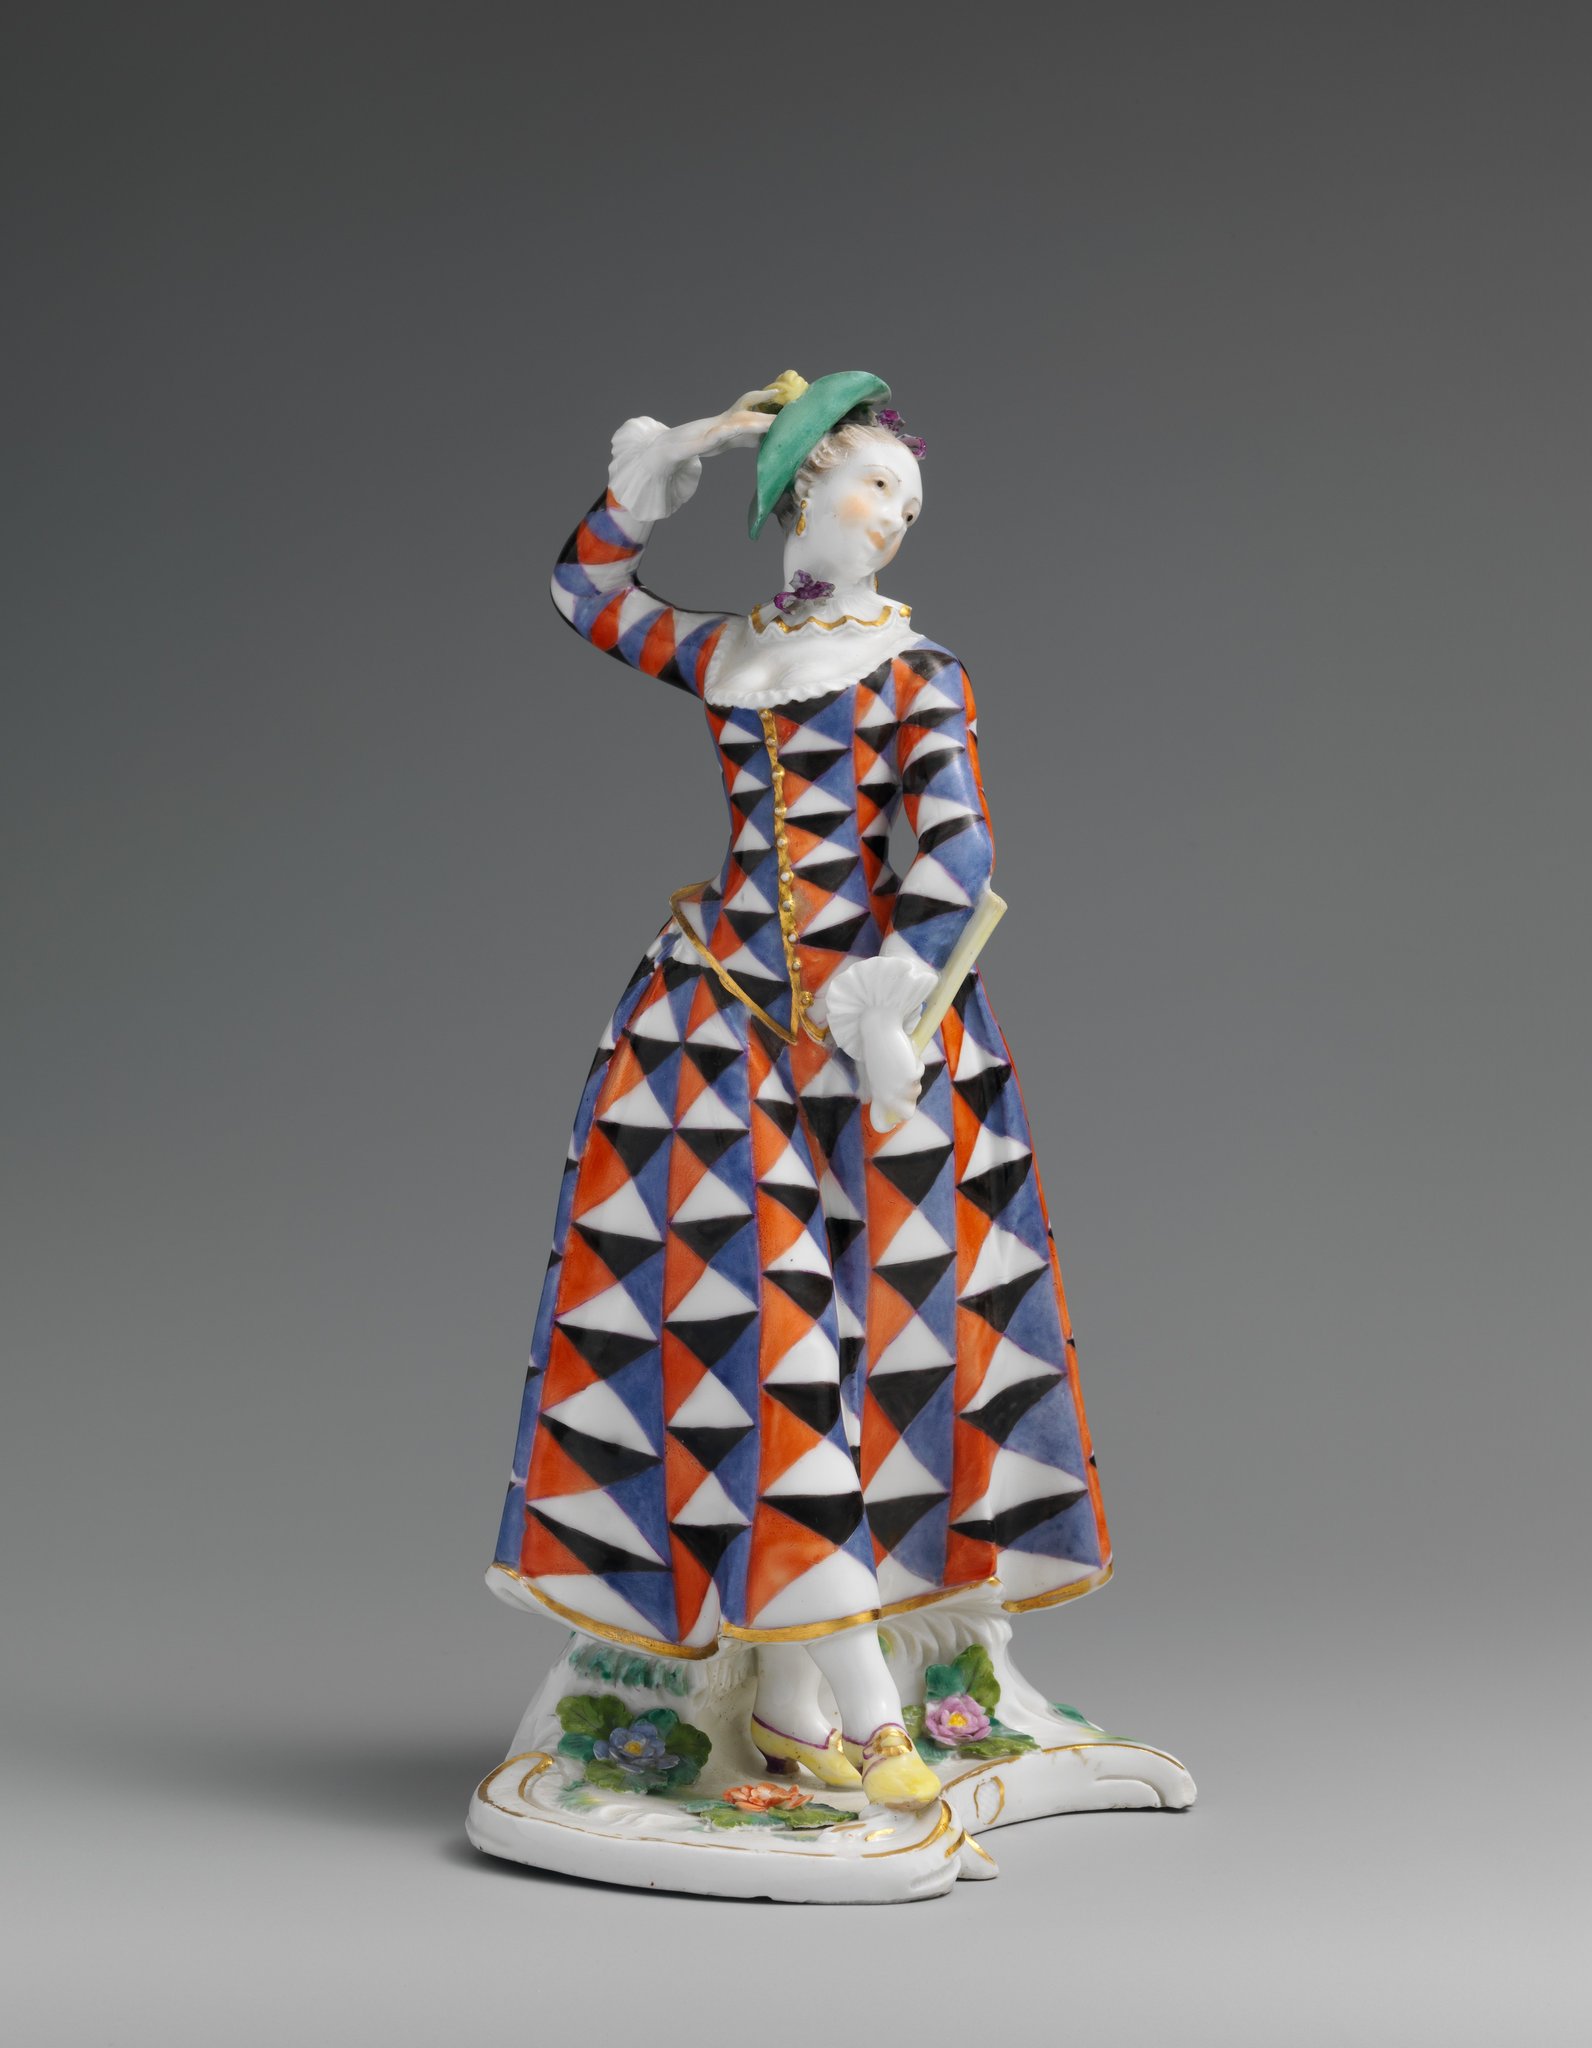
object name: figure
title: Harlequina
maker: nymphenburg porcelain manufactory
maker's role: manufactory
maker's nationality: german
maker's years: 1747-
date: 1760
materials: hard paste porcelain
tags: women